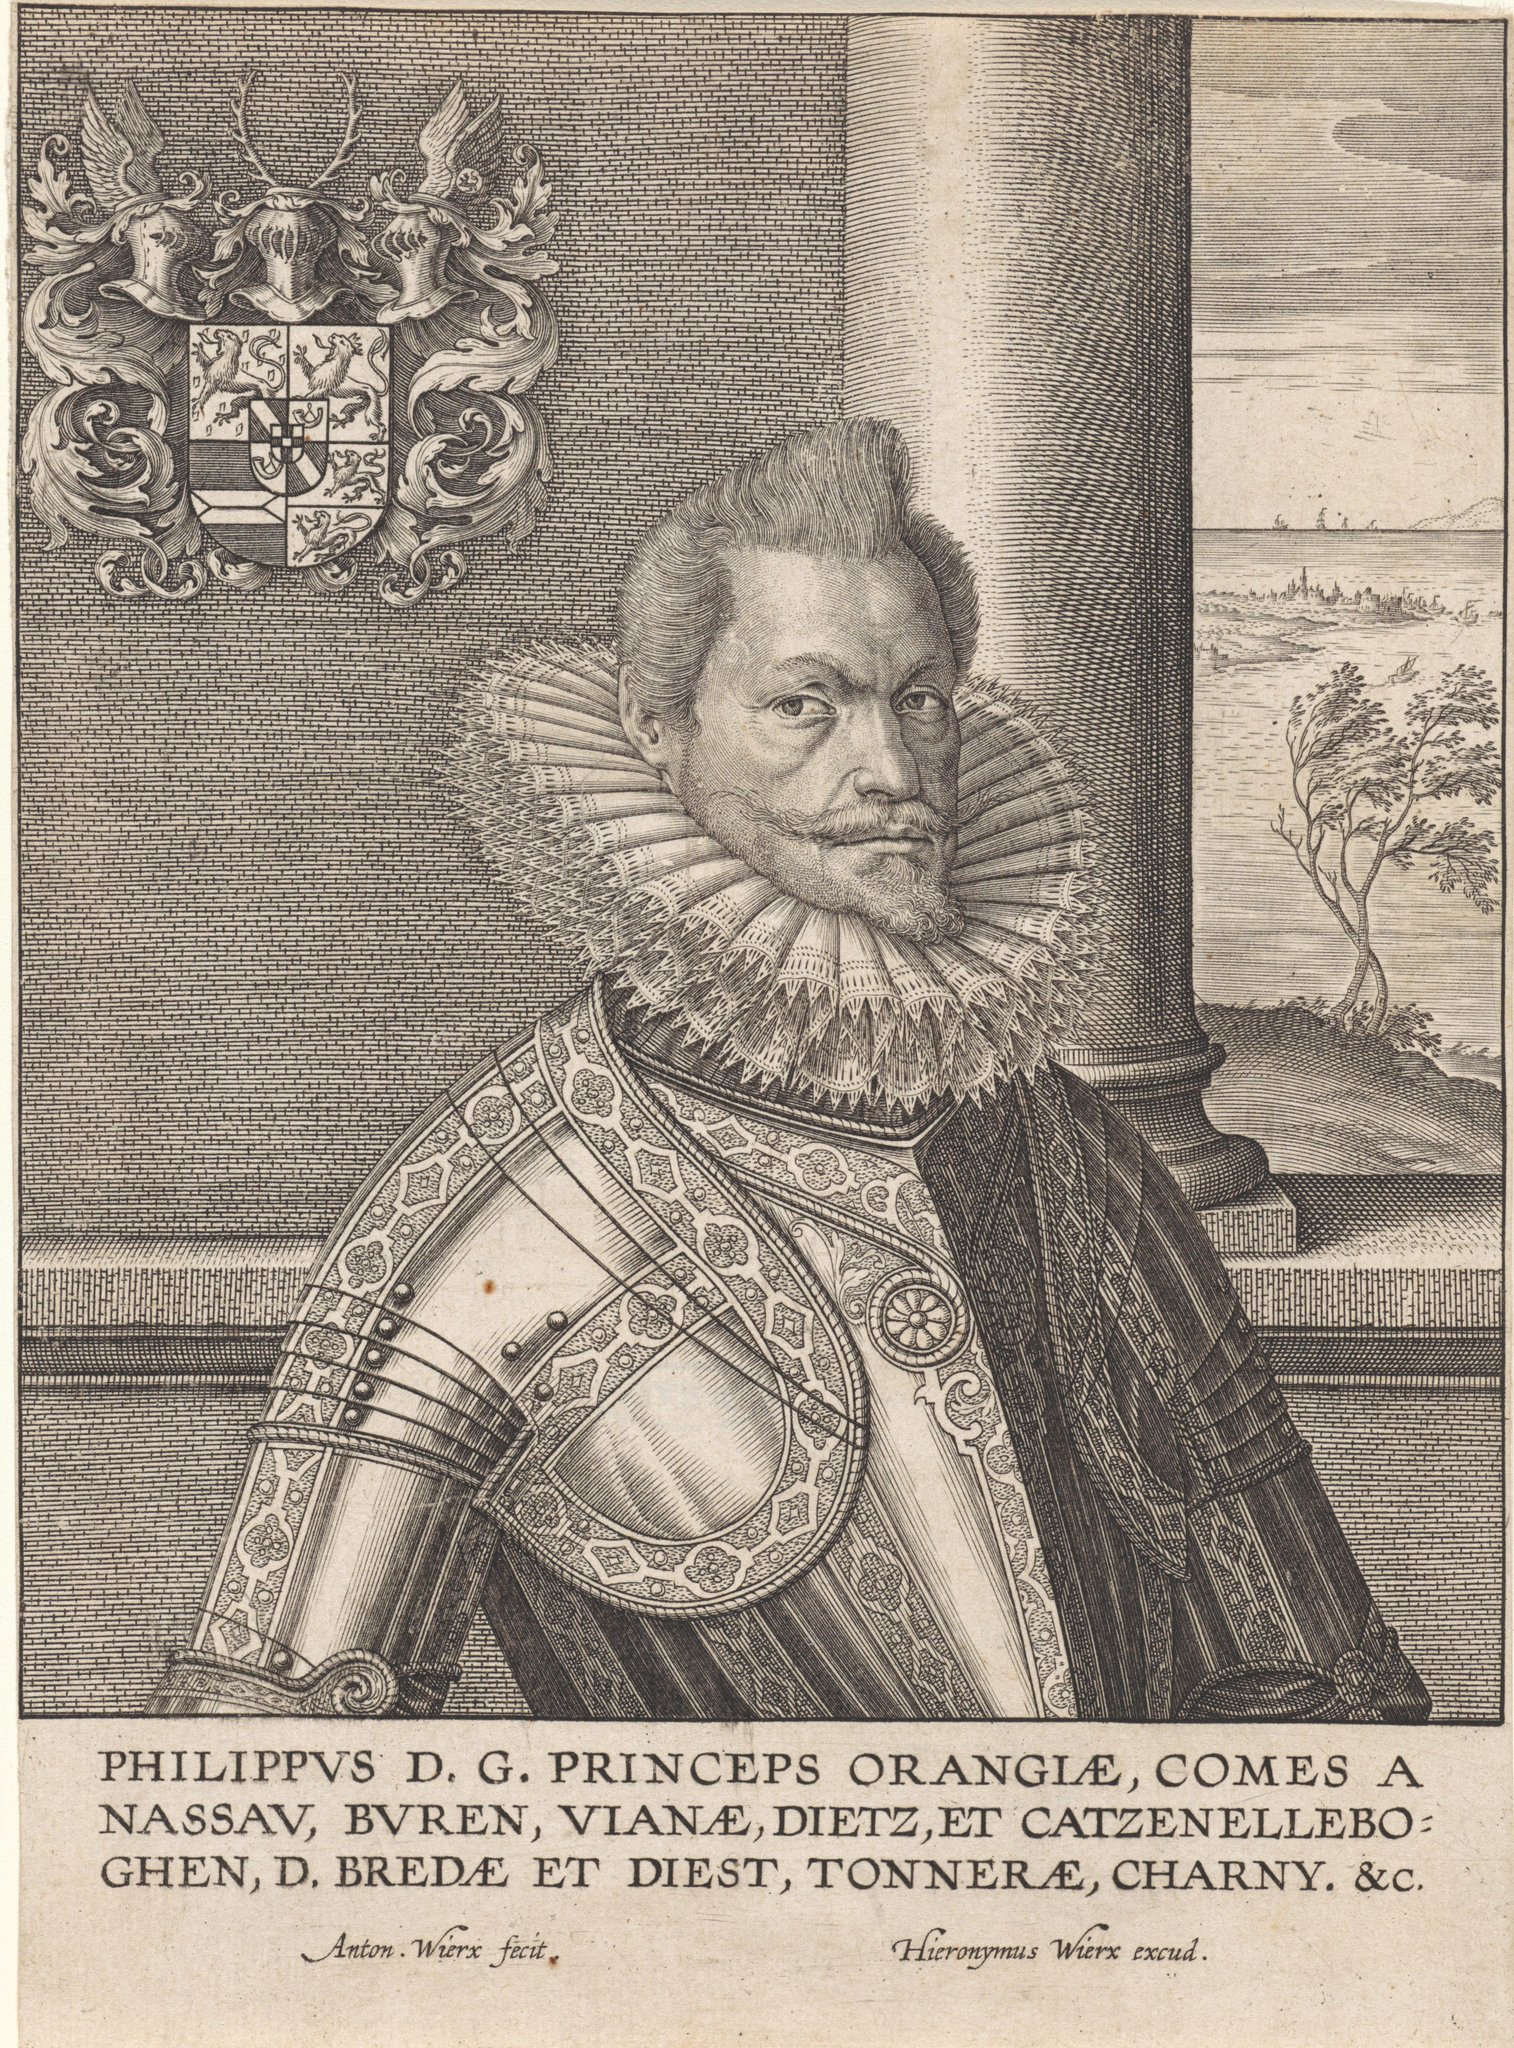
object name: print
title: Busteportret van Filips Willem, prins van Oranje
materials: paper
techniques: engraving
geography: antwerp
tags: buren, bruges, filips willem (prins van oranje), armour, armorial bearing, heraldry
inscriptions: collector's mark: Lugt 2228, collector's mark: Lugt 2760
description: Hij draagt een harnas. Linksboven zijn wapenschild. Op de achtergrond door het venster een gezicht op de zee. In de marge een drieregelig onderschrift in het Latijn.